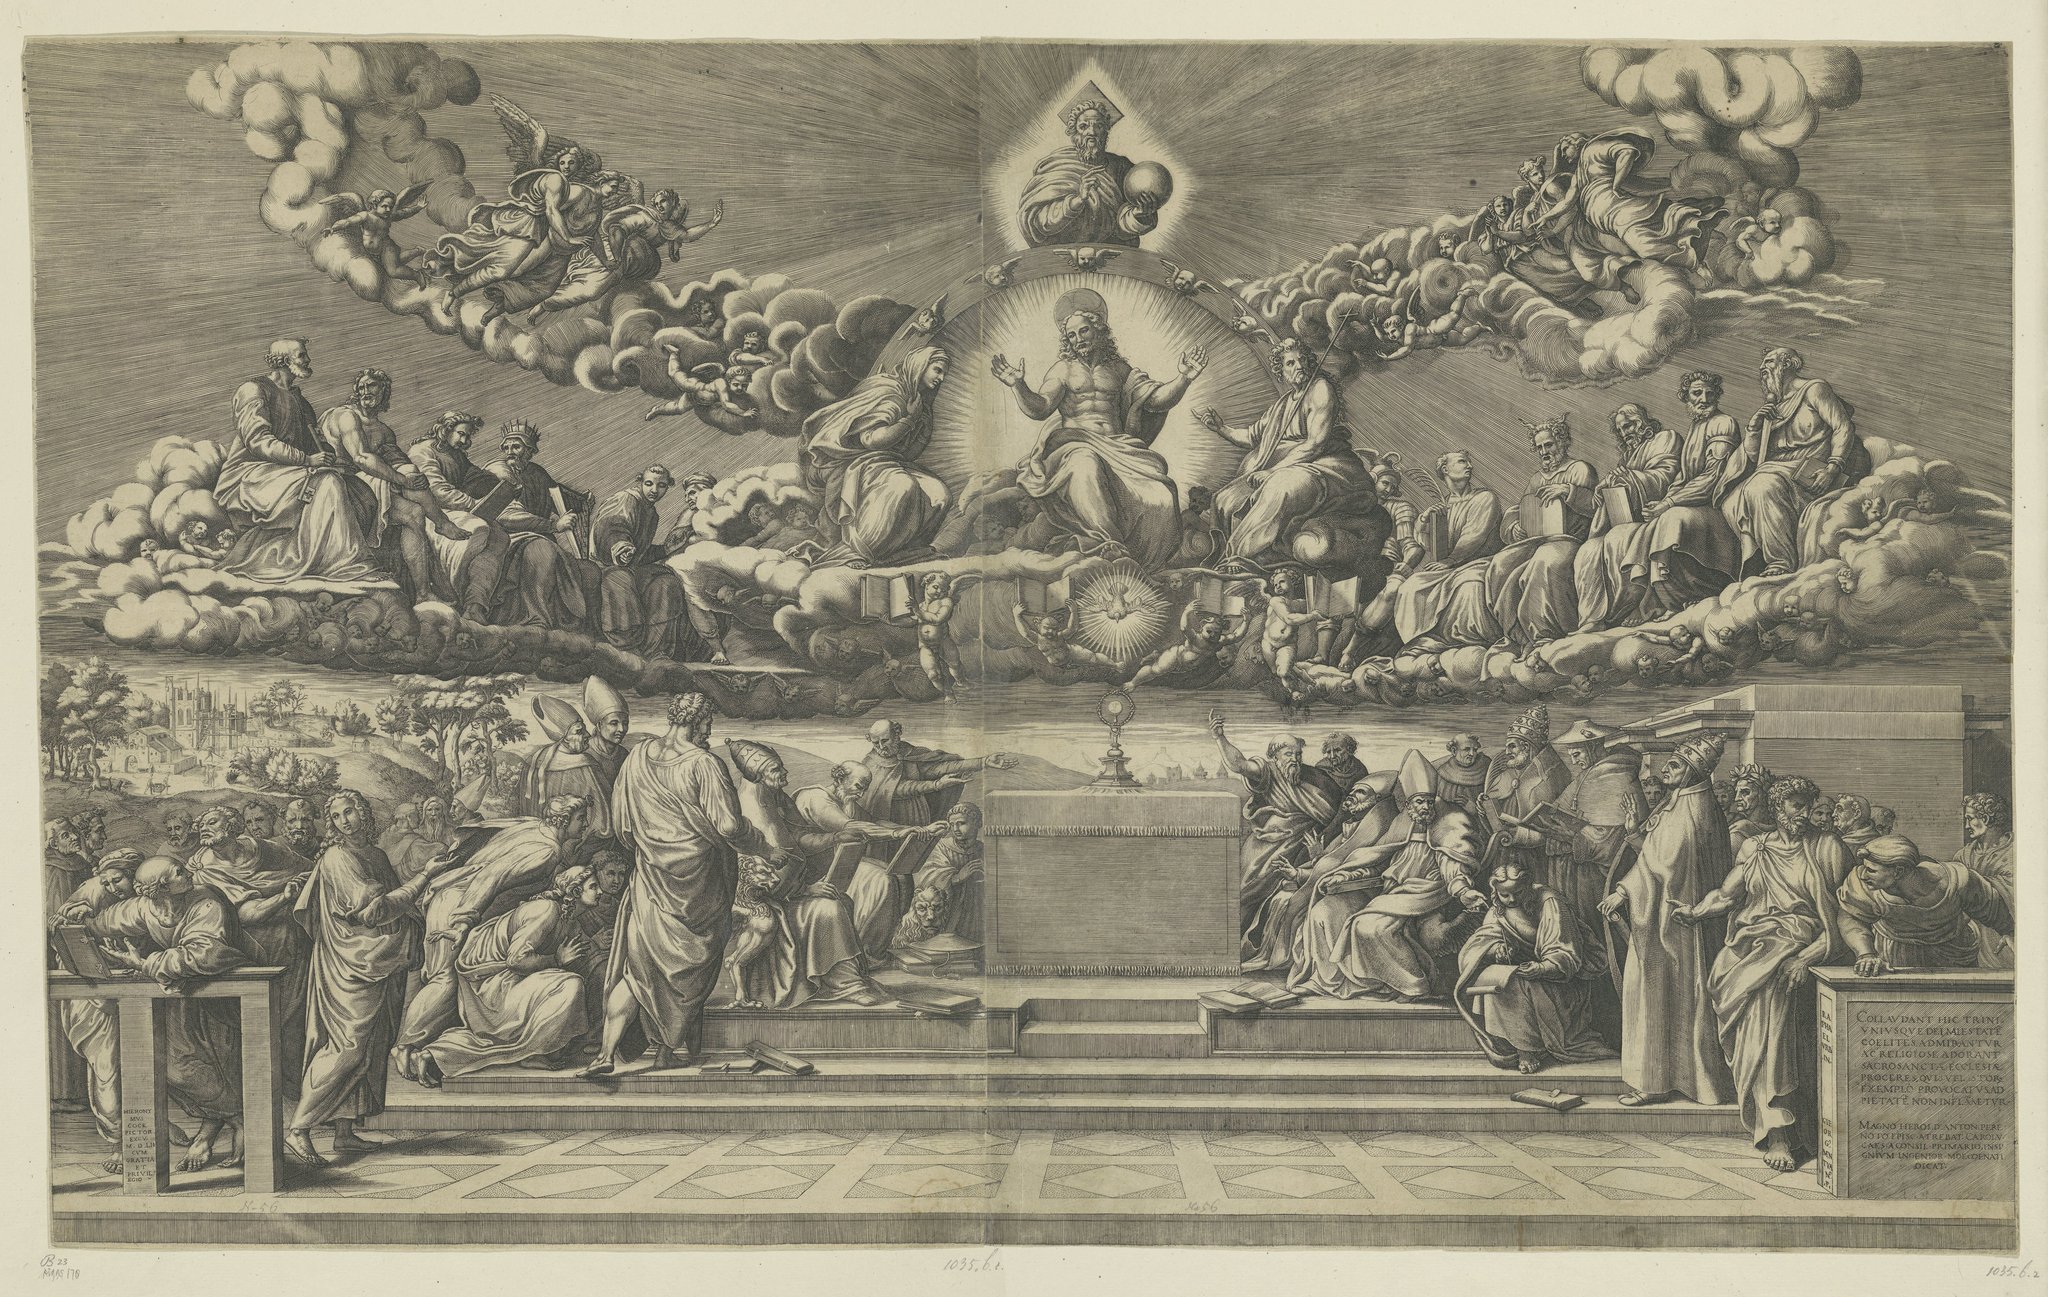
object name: print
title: Dispuut over het Heilige Sacrament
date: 1552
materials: paper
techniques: engraving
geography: italy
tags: dante alighieri, rome, priest, politician, representations of the trinity, the holy trinity, 'trinitas coelestis'; father, son and holy ghost ~ christian religion, saints, pope, angels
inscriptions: collector's mark: Lugt 240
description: Het fresco van Rafaël in de Stanza della Segnatura dat de bovennatuurlijke waarheid weergeeft. Het fresco bestaat uit twee niveaus, de hemel en de aarde. Op beide niveaus wordt een discussie gevoerd over het Heilige Sacrament of de eucharistie. Centraal God de Vader, Christus en de Heilige Geest boven een altaar. Naast Christus zitten Maria en Johannes de Doper. Ook aanwezig op de wolk zijn de apostelen, evangelisten en martelaren. Op het aardse niveau staan de heiligen en afgevaardigden van de kerk zoals paus Julius II, paus Sixtus IV, Savonarola en Dante Alighieri, die discussiëren over de transsubstantiatie. Boven zweven engelen.